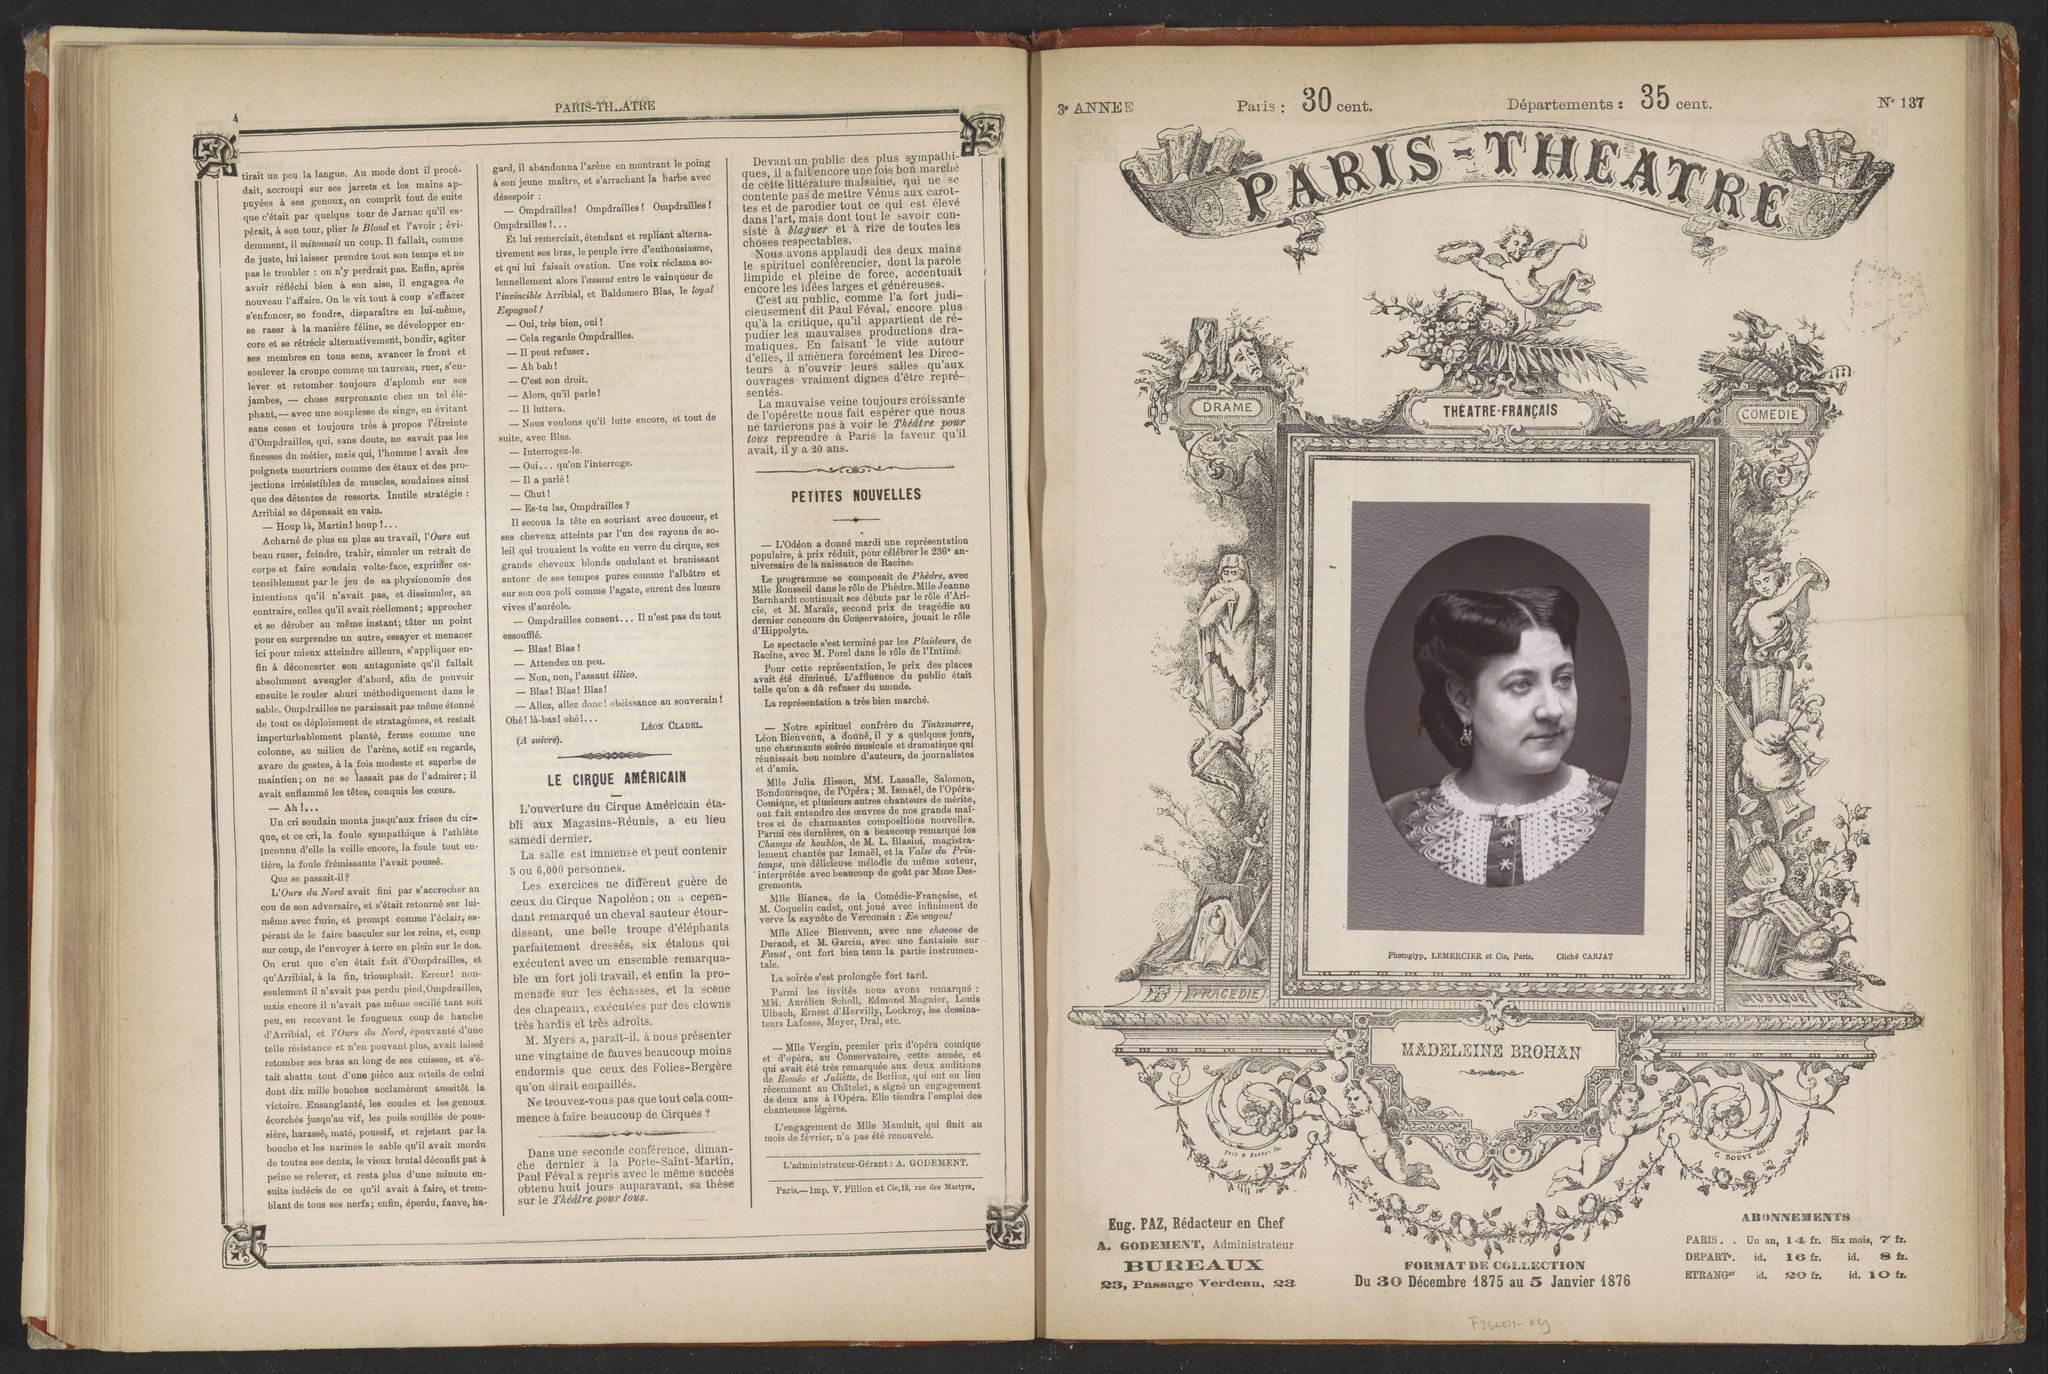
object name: page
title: Portret van Madeleine Brohan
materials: paper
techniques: woodburytype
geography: paris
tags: portrait of actor, actress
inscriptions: inscription: ‘Du 30 Décembre 1875 au 5 Janvier 1876’, number: ‘No 137’